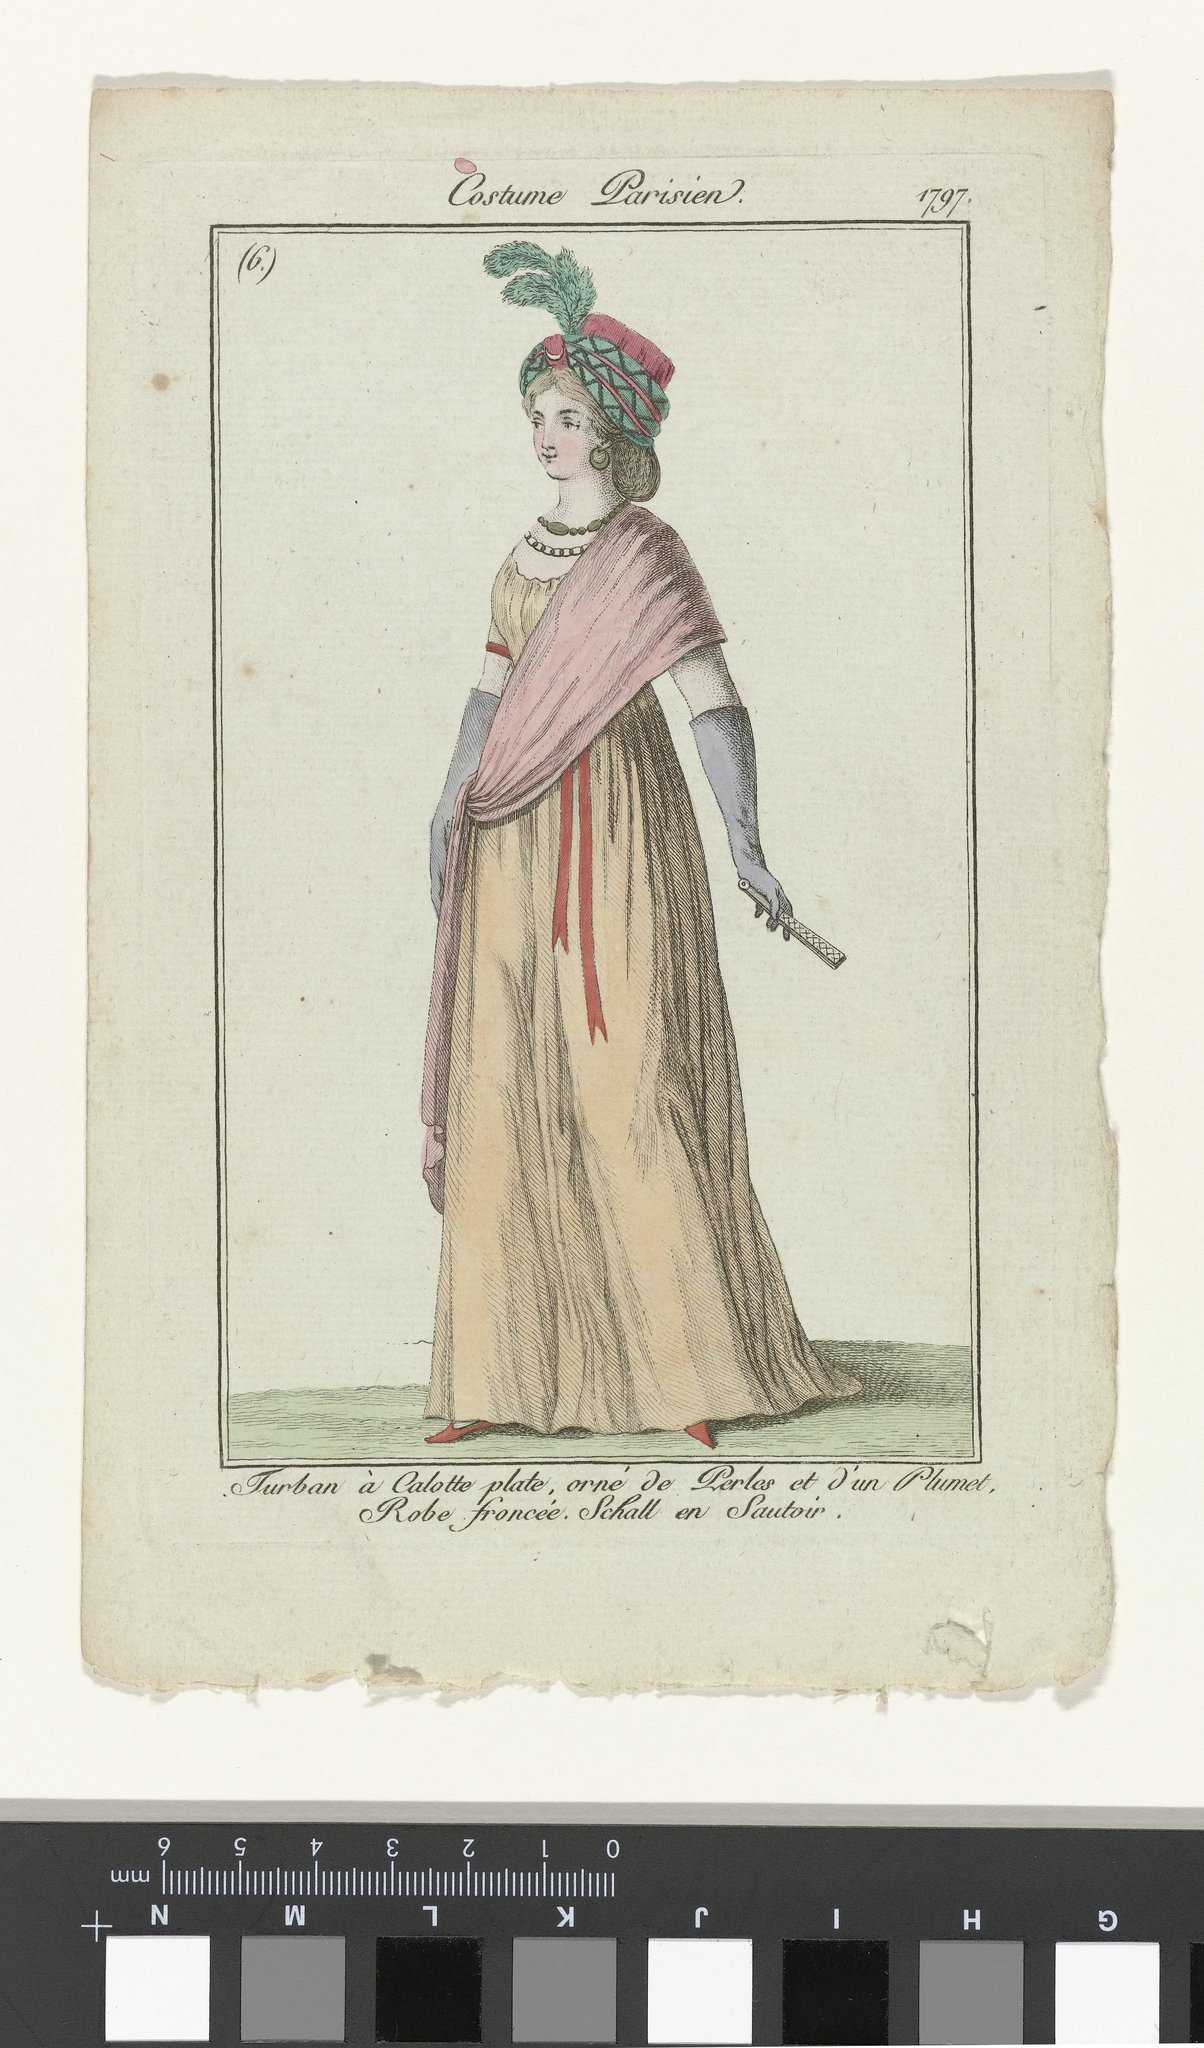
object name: fashion print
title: Journal des Dames et des Modes, Costume Parisien, 21 septembre 1797, (6)(bis): Turban à Calott (...)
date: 1797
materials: paper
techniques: engraving, hand coloring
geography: paris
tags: ear-rings (+ women's clothes), head-gear: turban (+ women's clothes), gloves, mittens (long gloves) (+ women's clothes), clothing for the upper part of the body (shawl) (+ women's clothes), fashion plates, dress, gown (+ women's clothes), fan (+ women's clothes), necklace (+ women's clothes)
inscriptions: title: ‘Costume Parisien.’, caption: ‘Turban à Calotte plate, orné de Perles et d'un Plumet. Robe froncée. Schall en Sautoir.’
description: Staande vrouw met op het hoofd een tulband met een platte bovenkant: 'turban à Calotte', versierd met parels en pluimen. Zij draagt een japon met sleep, in de taille gesmockt. Schuin over de borst een lange sjaal. Verdere accessoires: in het linkeroor een oorring, twee verschillende kettingen, lange handschoenen, waaier, platte schoenen met puntige neuzen. De prent maakt deel uit van het modetijdschrift Journal des Dames et des Modes, uitgegeven door Sellèque, Parijs, 1797-1839.